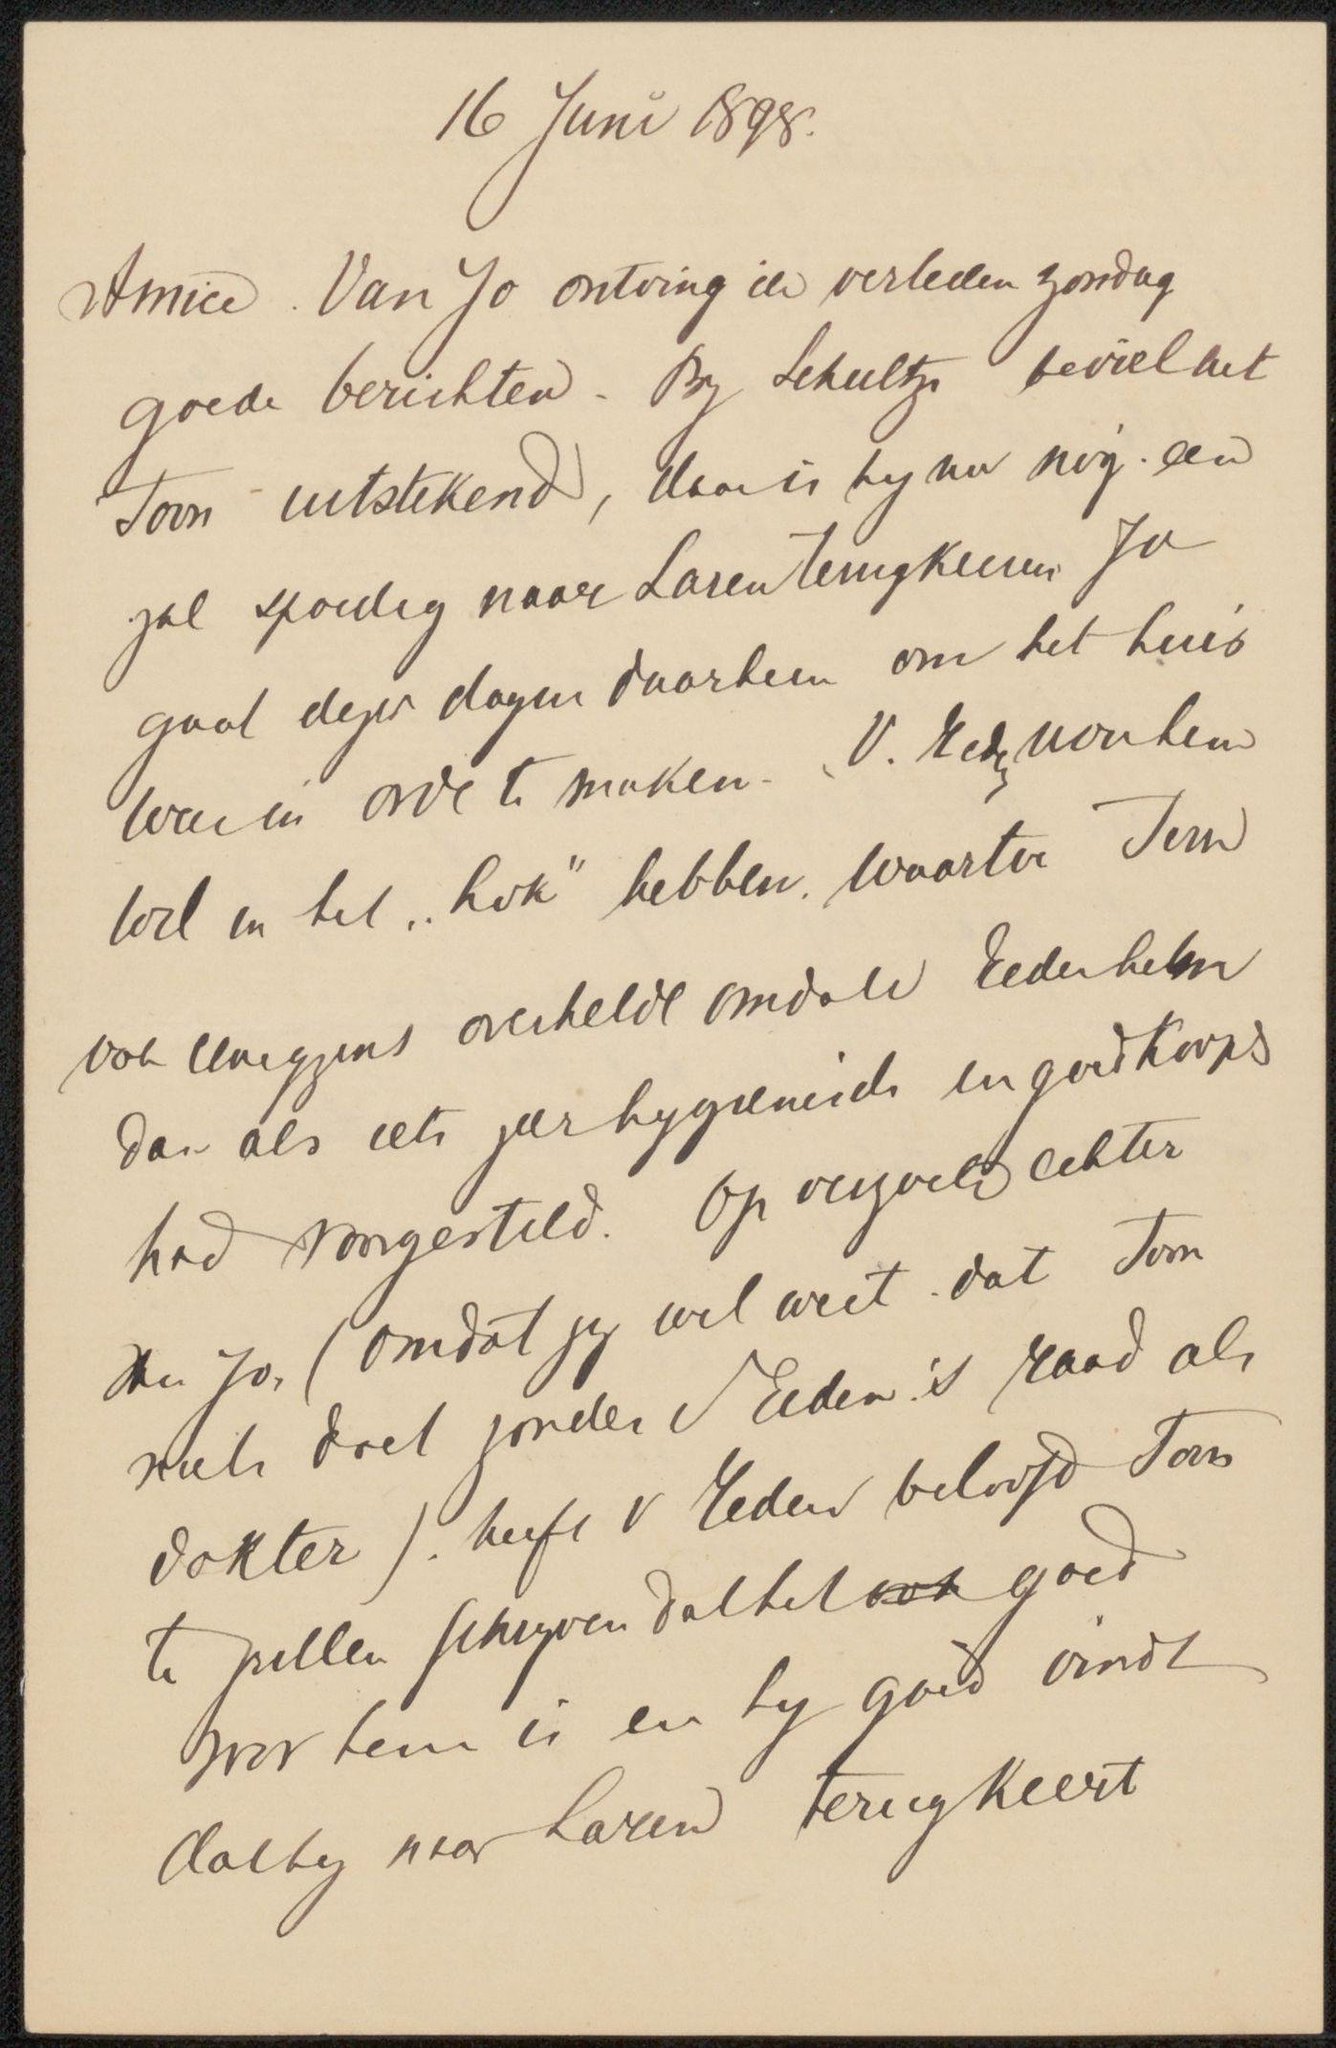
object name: letter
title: Brief aan Jan Veth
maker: alphons diepenbrock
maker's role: componist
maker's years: 1862-1921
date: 1898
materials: ink, paper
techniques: pen, writing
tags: dordrecht, amsterdam, painter, print maker, draughtsman, designer, jan veth, utrecht, johanna henriëtte besier, den bosch, antoon derkinderen, haarlem, frederik van eeden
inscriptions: collector's mark: ‘RPK’